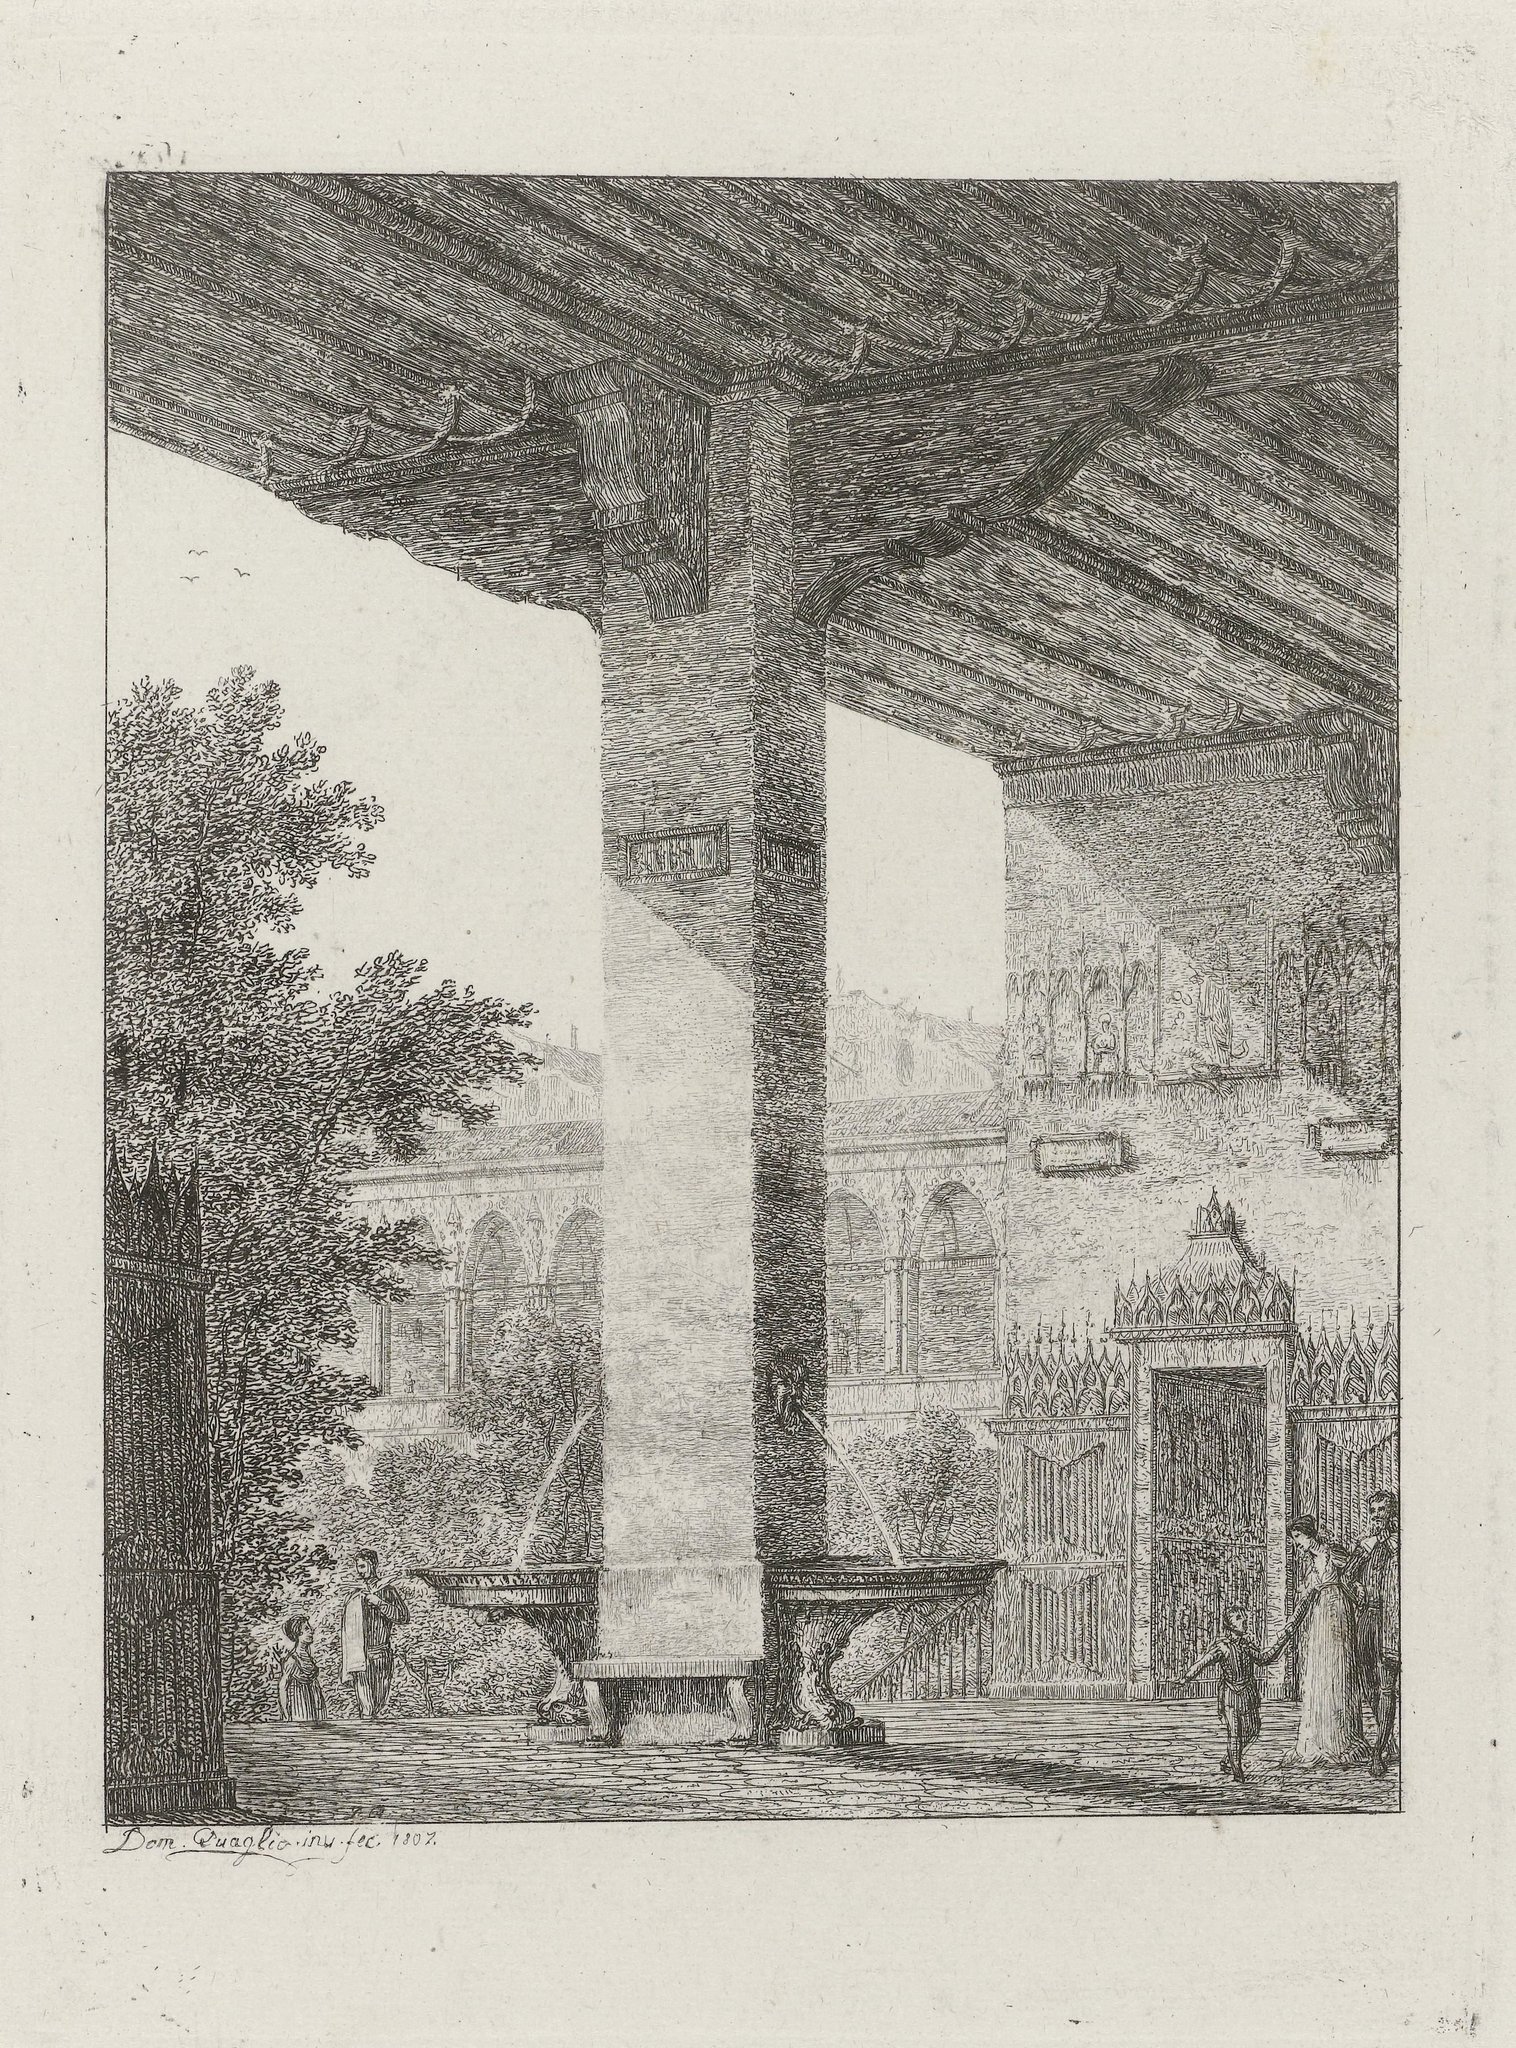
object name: print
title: Vier und Zwanzig Landschaftliche Gegenstände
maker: johann velten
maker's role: print maker, publisher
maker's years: 1784-1864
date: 1807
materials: paper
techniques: etching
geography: karlsruhe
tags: courtyard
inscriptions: collector's mark: Lugt 2760, collector's mark: Lugt 2228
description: Deze prent maakt deel uit van een serie van 24 prenten.